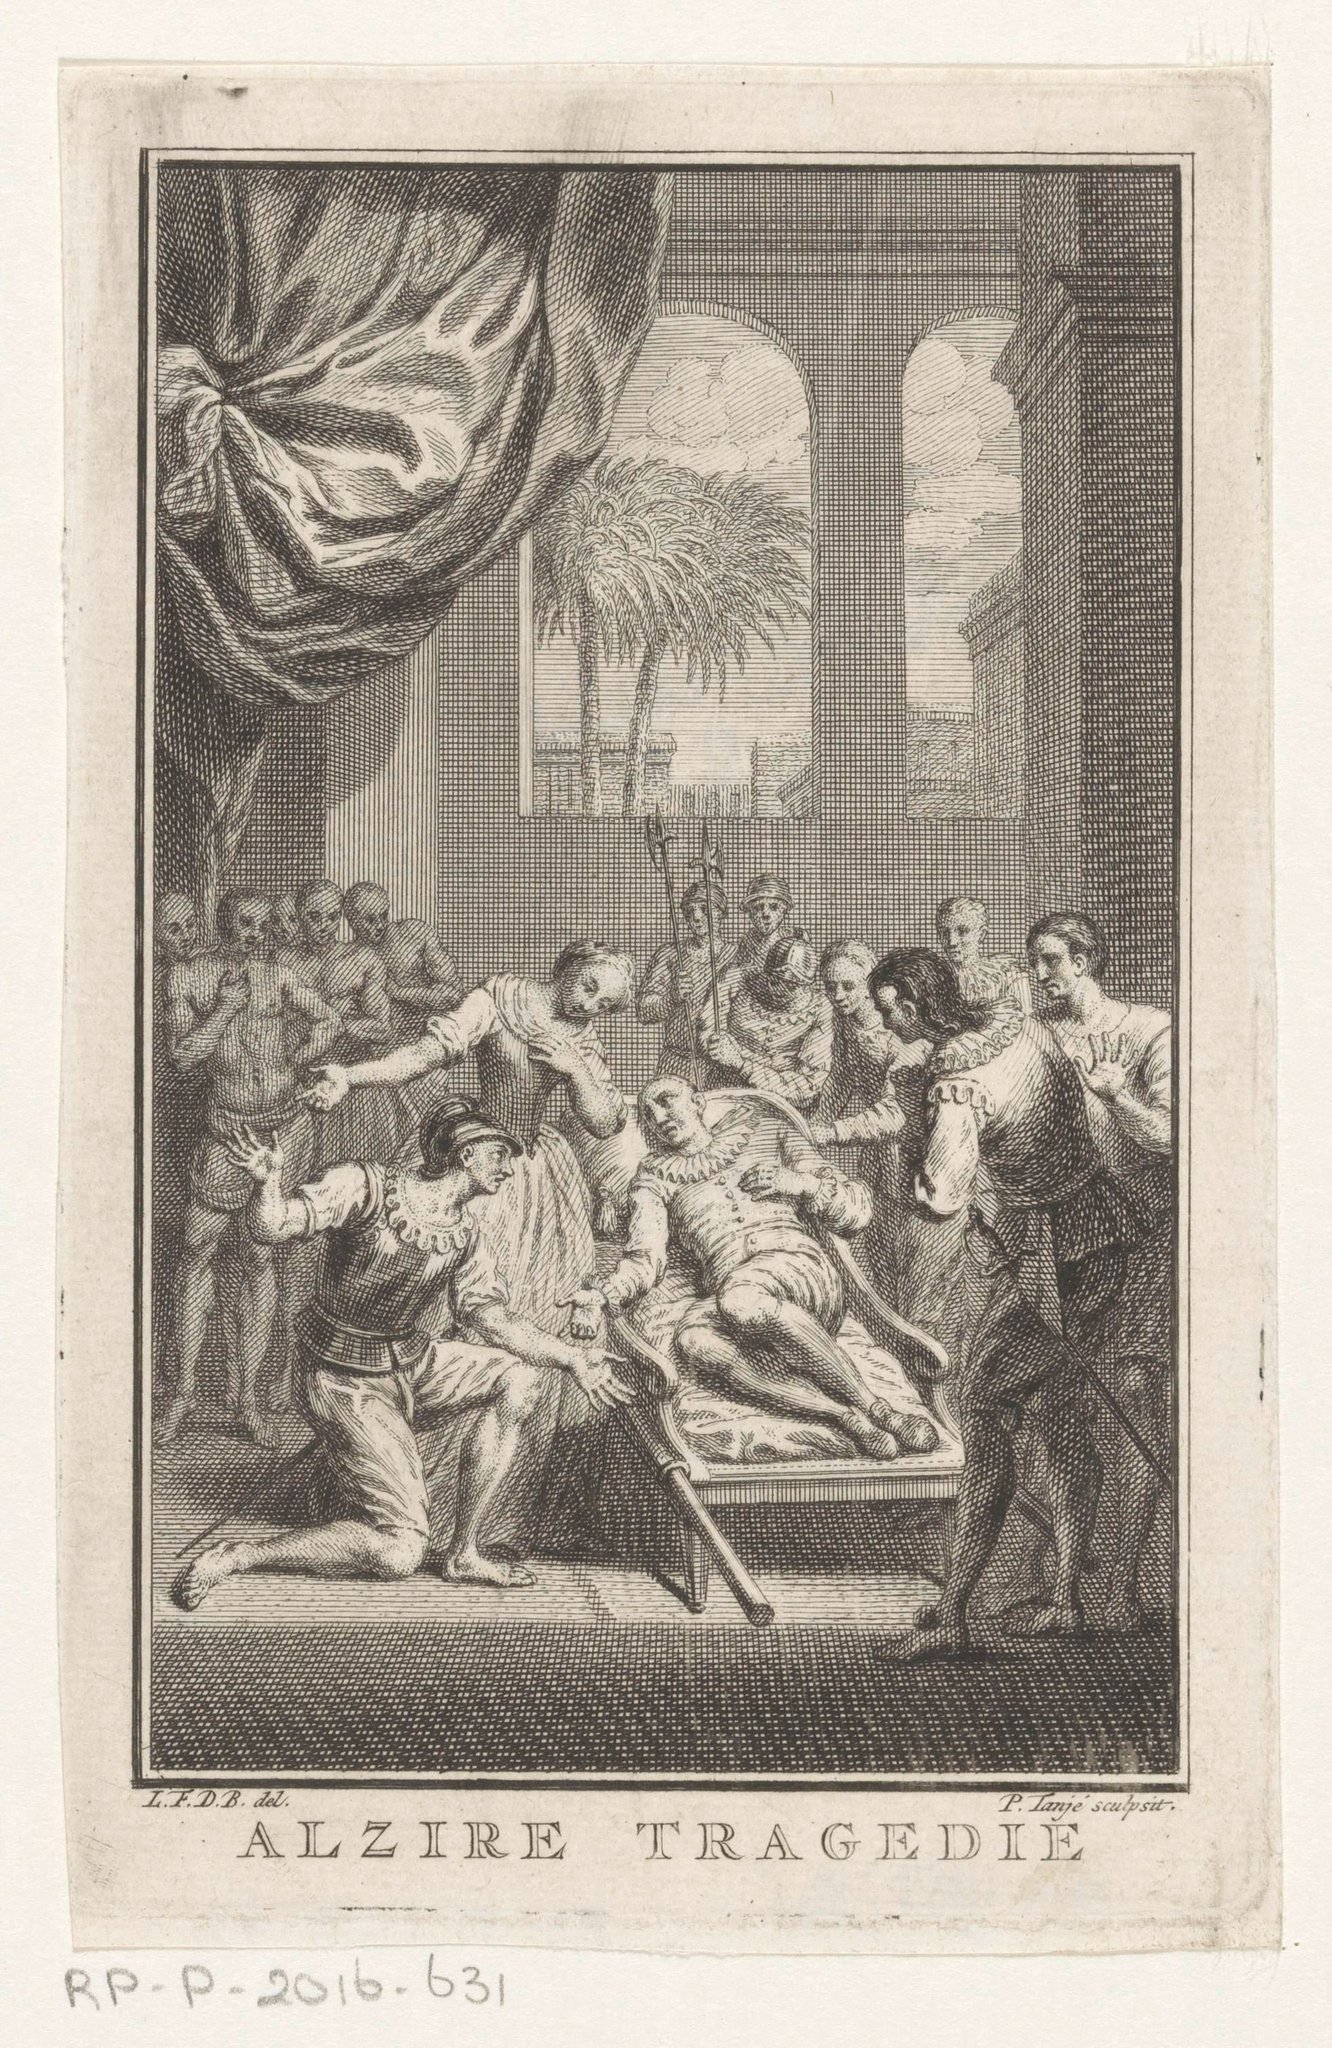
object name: print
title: Man op sterfbed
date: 1770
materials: paper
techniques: engraving, etching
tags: deathbed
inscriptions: collector's mark: Lugt 2228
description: Boekillustratie bij de tragedie van Alzire van Voltaire, 1770. Prent afkomstig uit een plakalbum met titelprenten, ornamenten etc. op blauw papier in 1983 uit elkaar gehaald.